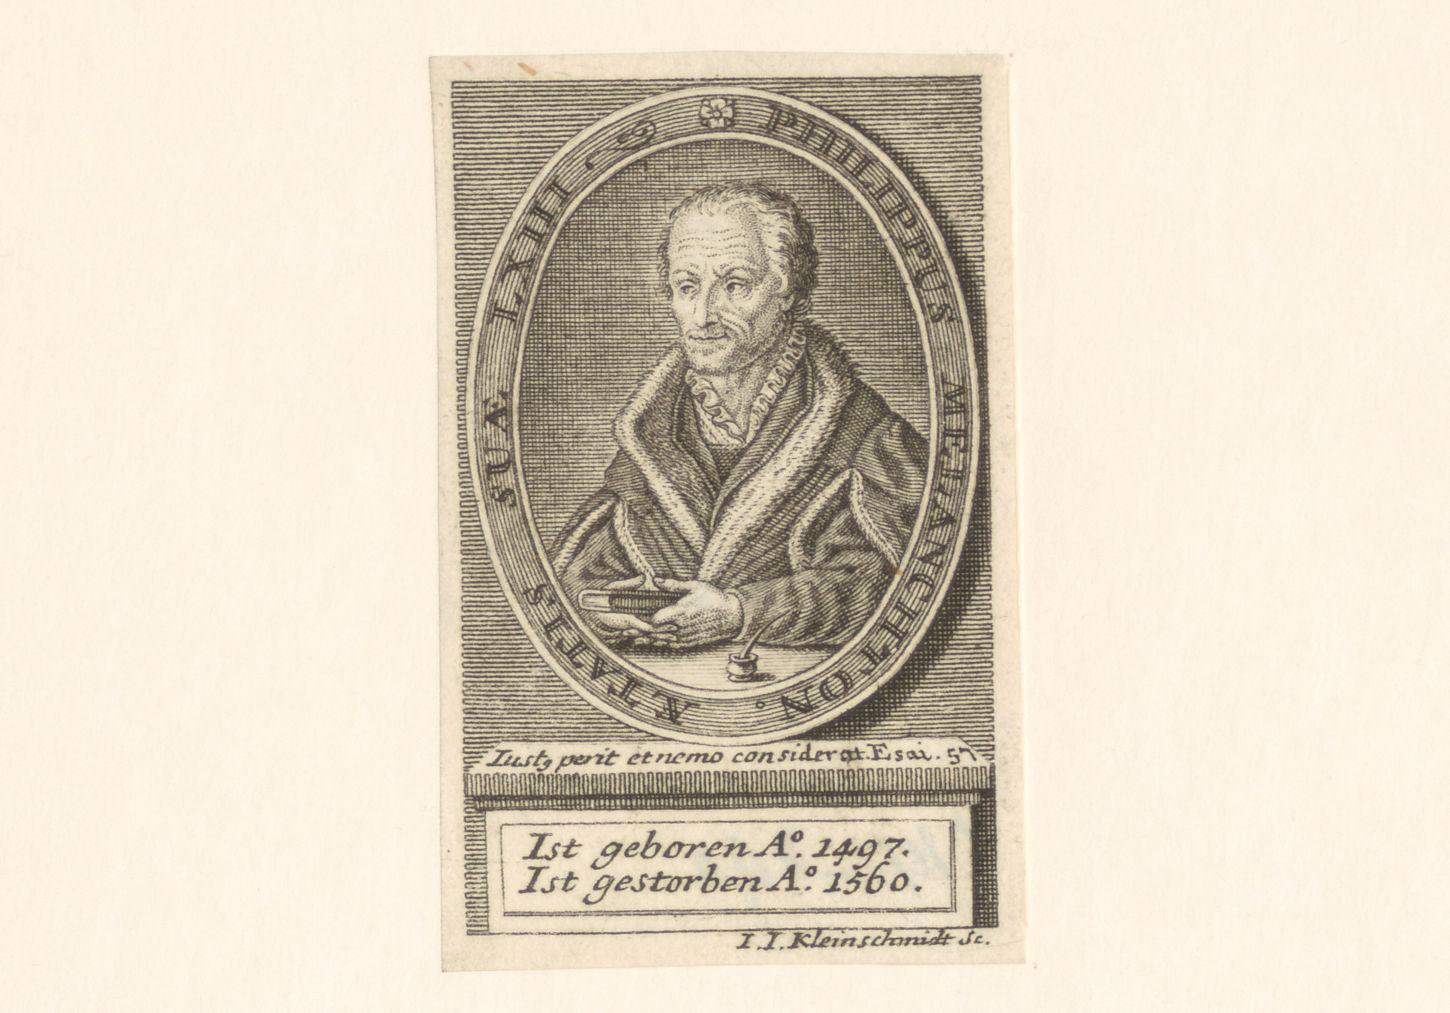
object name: print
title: Portret van Philipp Melanchthon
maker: johann jakob kleinschmidt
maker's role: artist, print maker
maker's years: 1687-1772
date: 1697-1772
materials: paper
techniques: engraving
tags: theologian, historical persons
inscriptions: collector's mark: Lugt 2228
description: Tekst in het Latijn in de omlijsting en in de ondermarge.